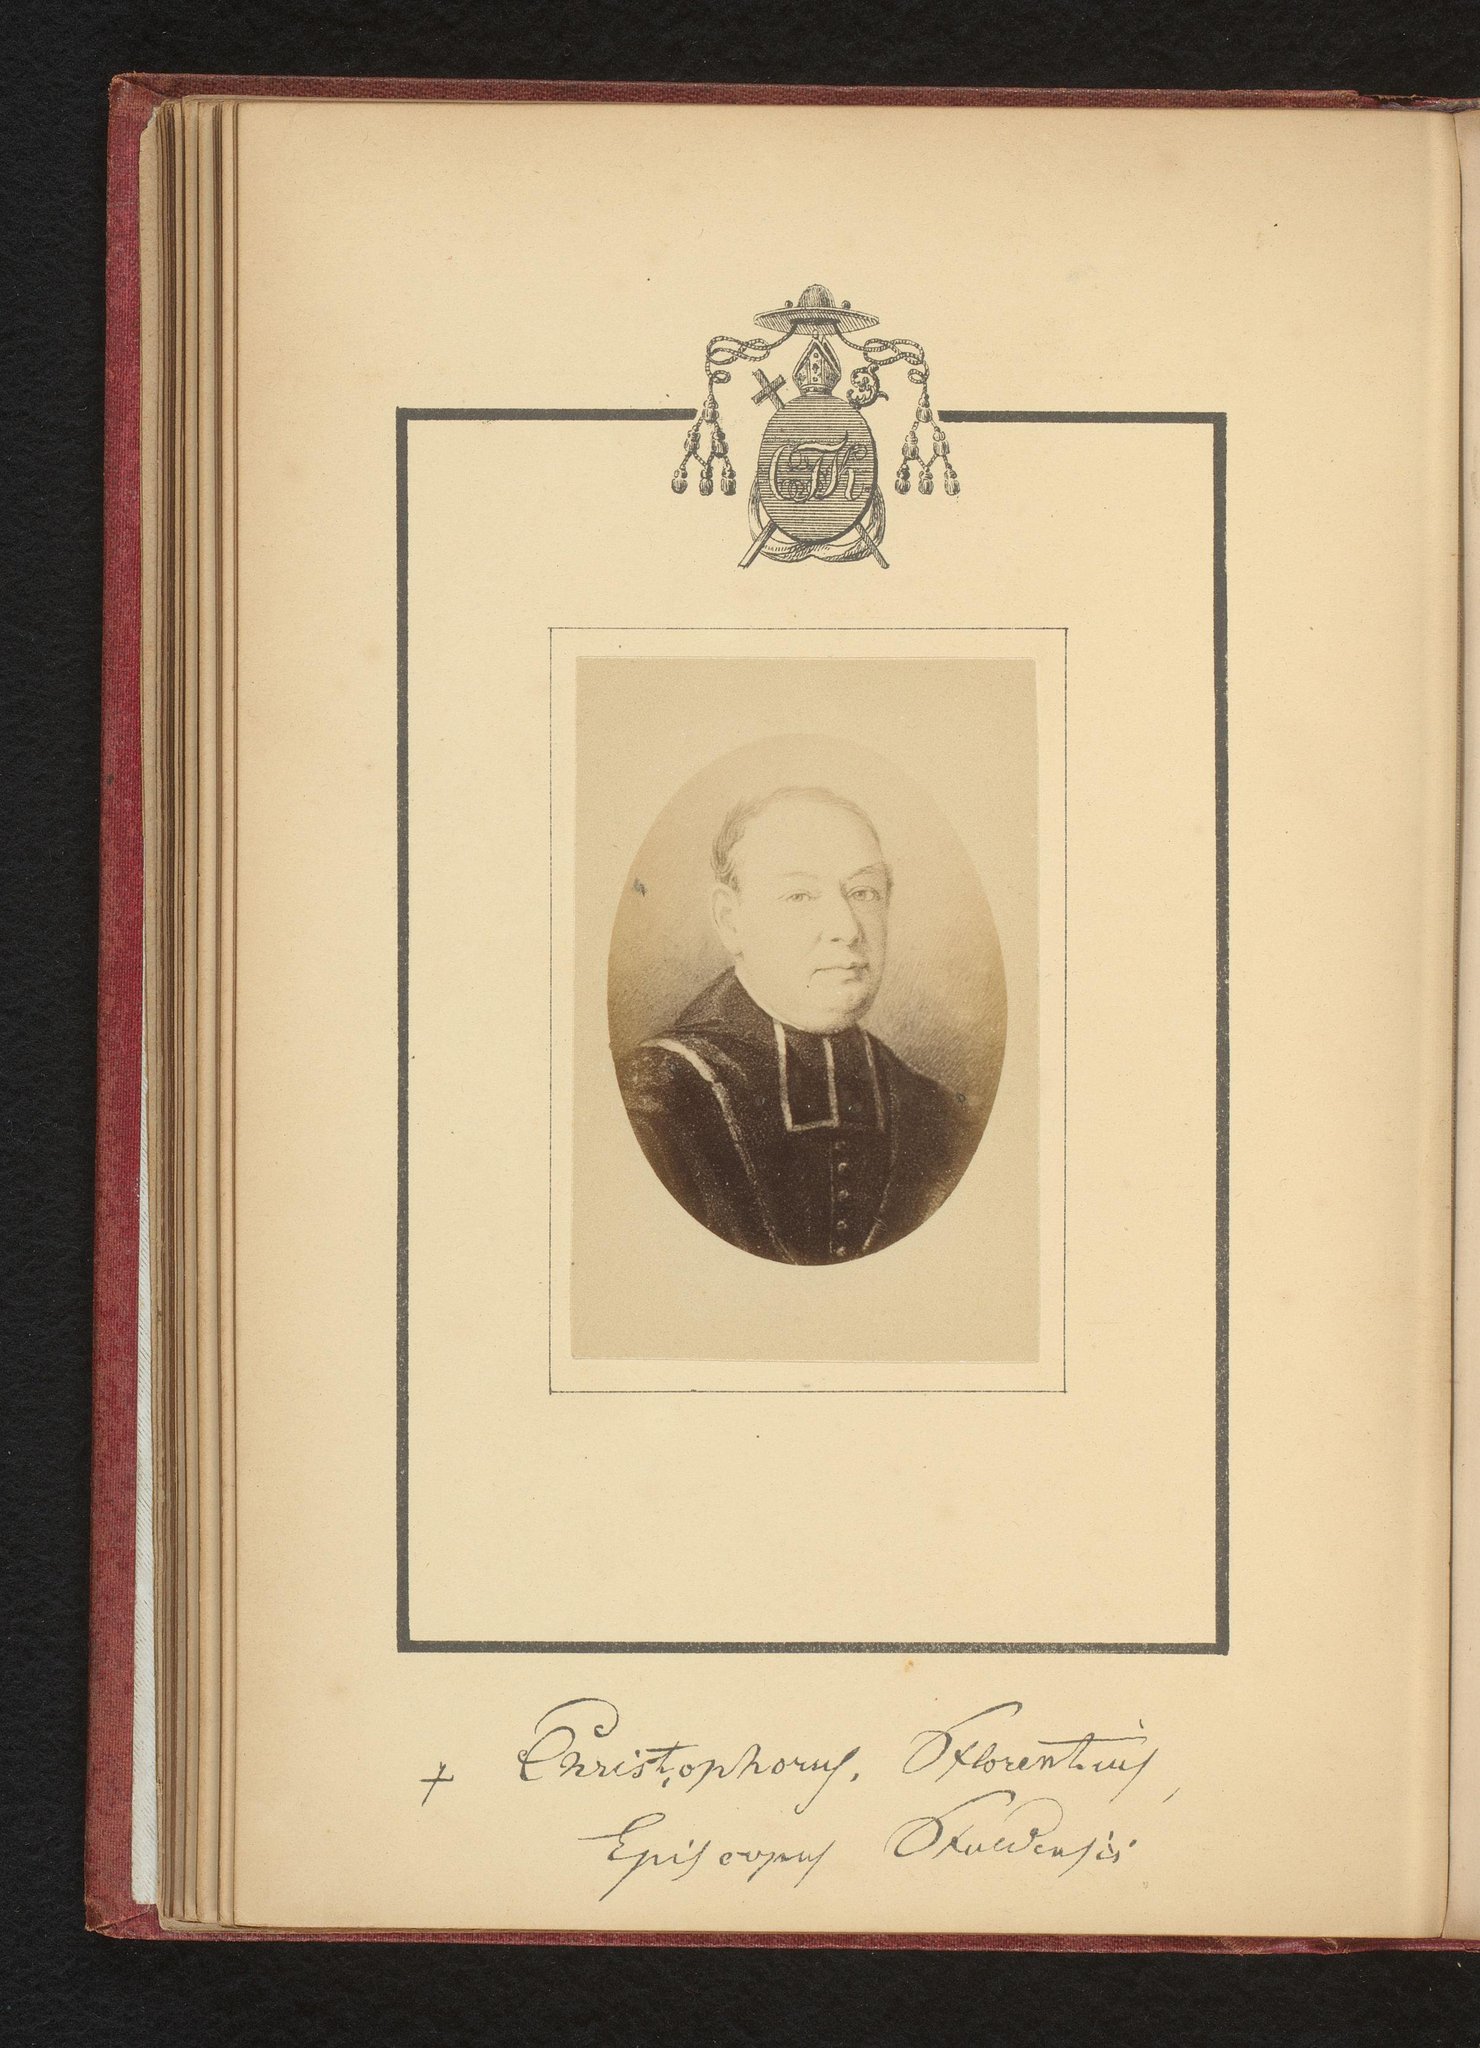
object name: page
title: Fotoreproductie van een portret van bisschop Christoph Florentius Kött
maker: Anonymous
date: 1863-1873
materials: photographic support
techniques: albumen print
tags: archbishop, bishop, etc. (roman catholic)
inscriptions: inscription: ‘Christophory, [...]’